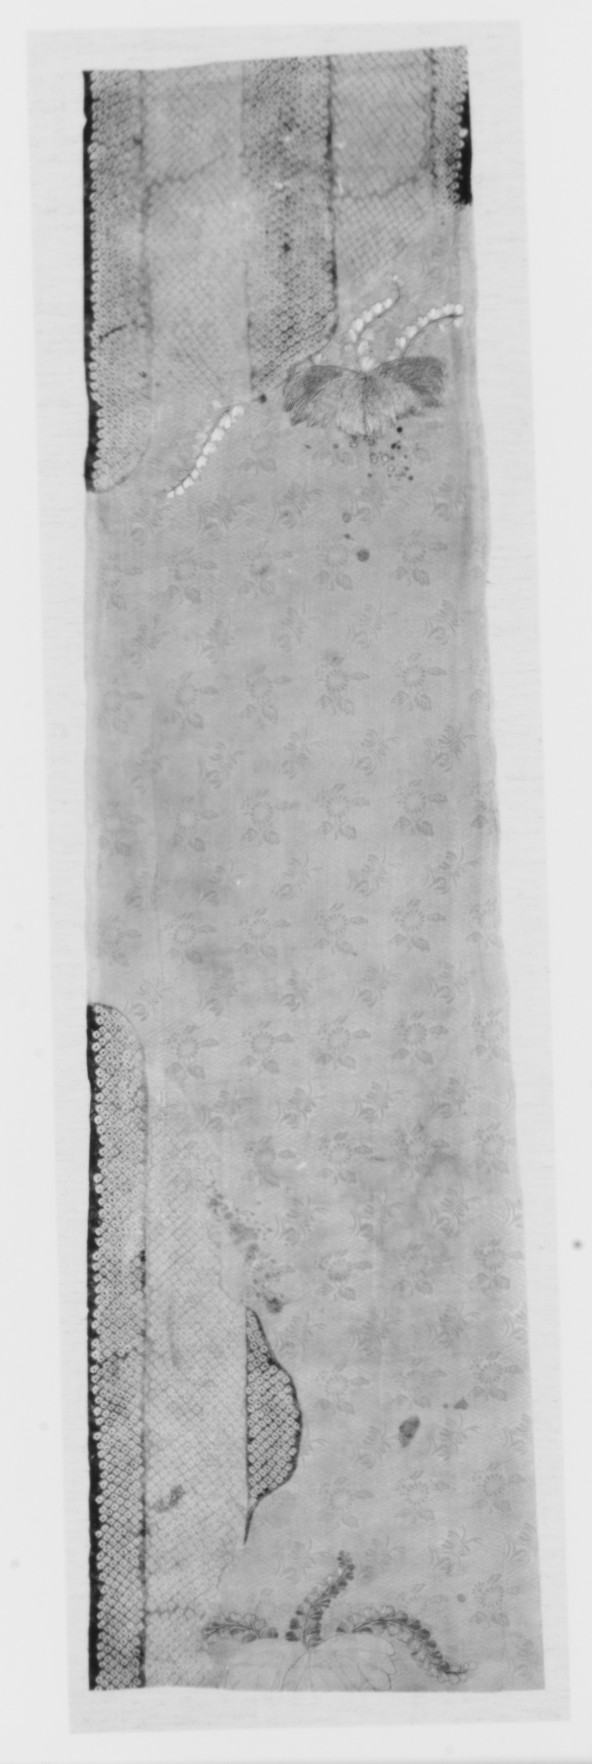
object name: piece from a kosode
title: Kosode Fragment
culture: japanese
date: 1615-1868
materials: textile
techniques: damask